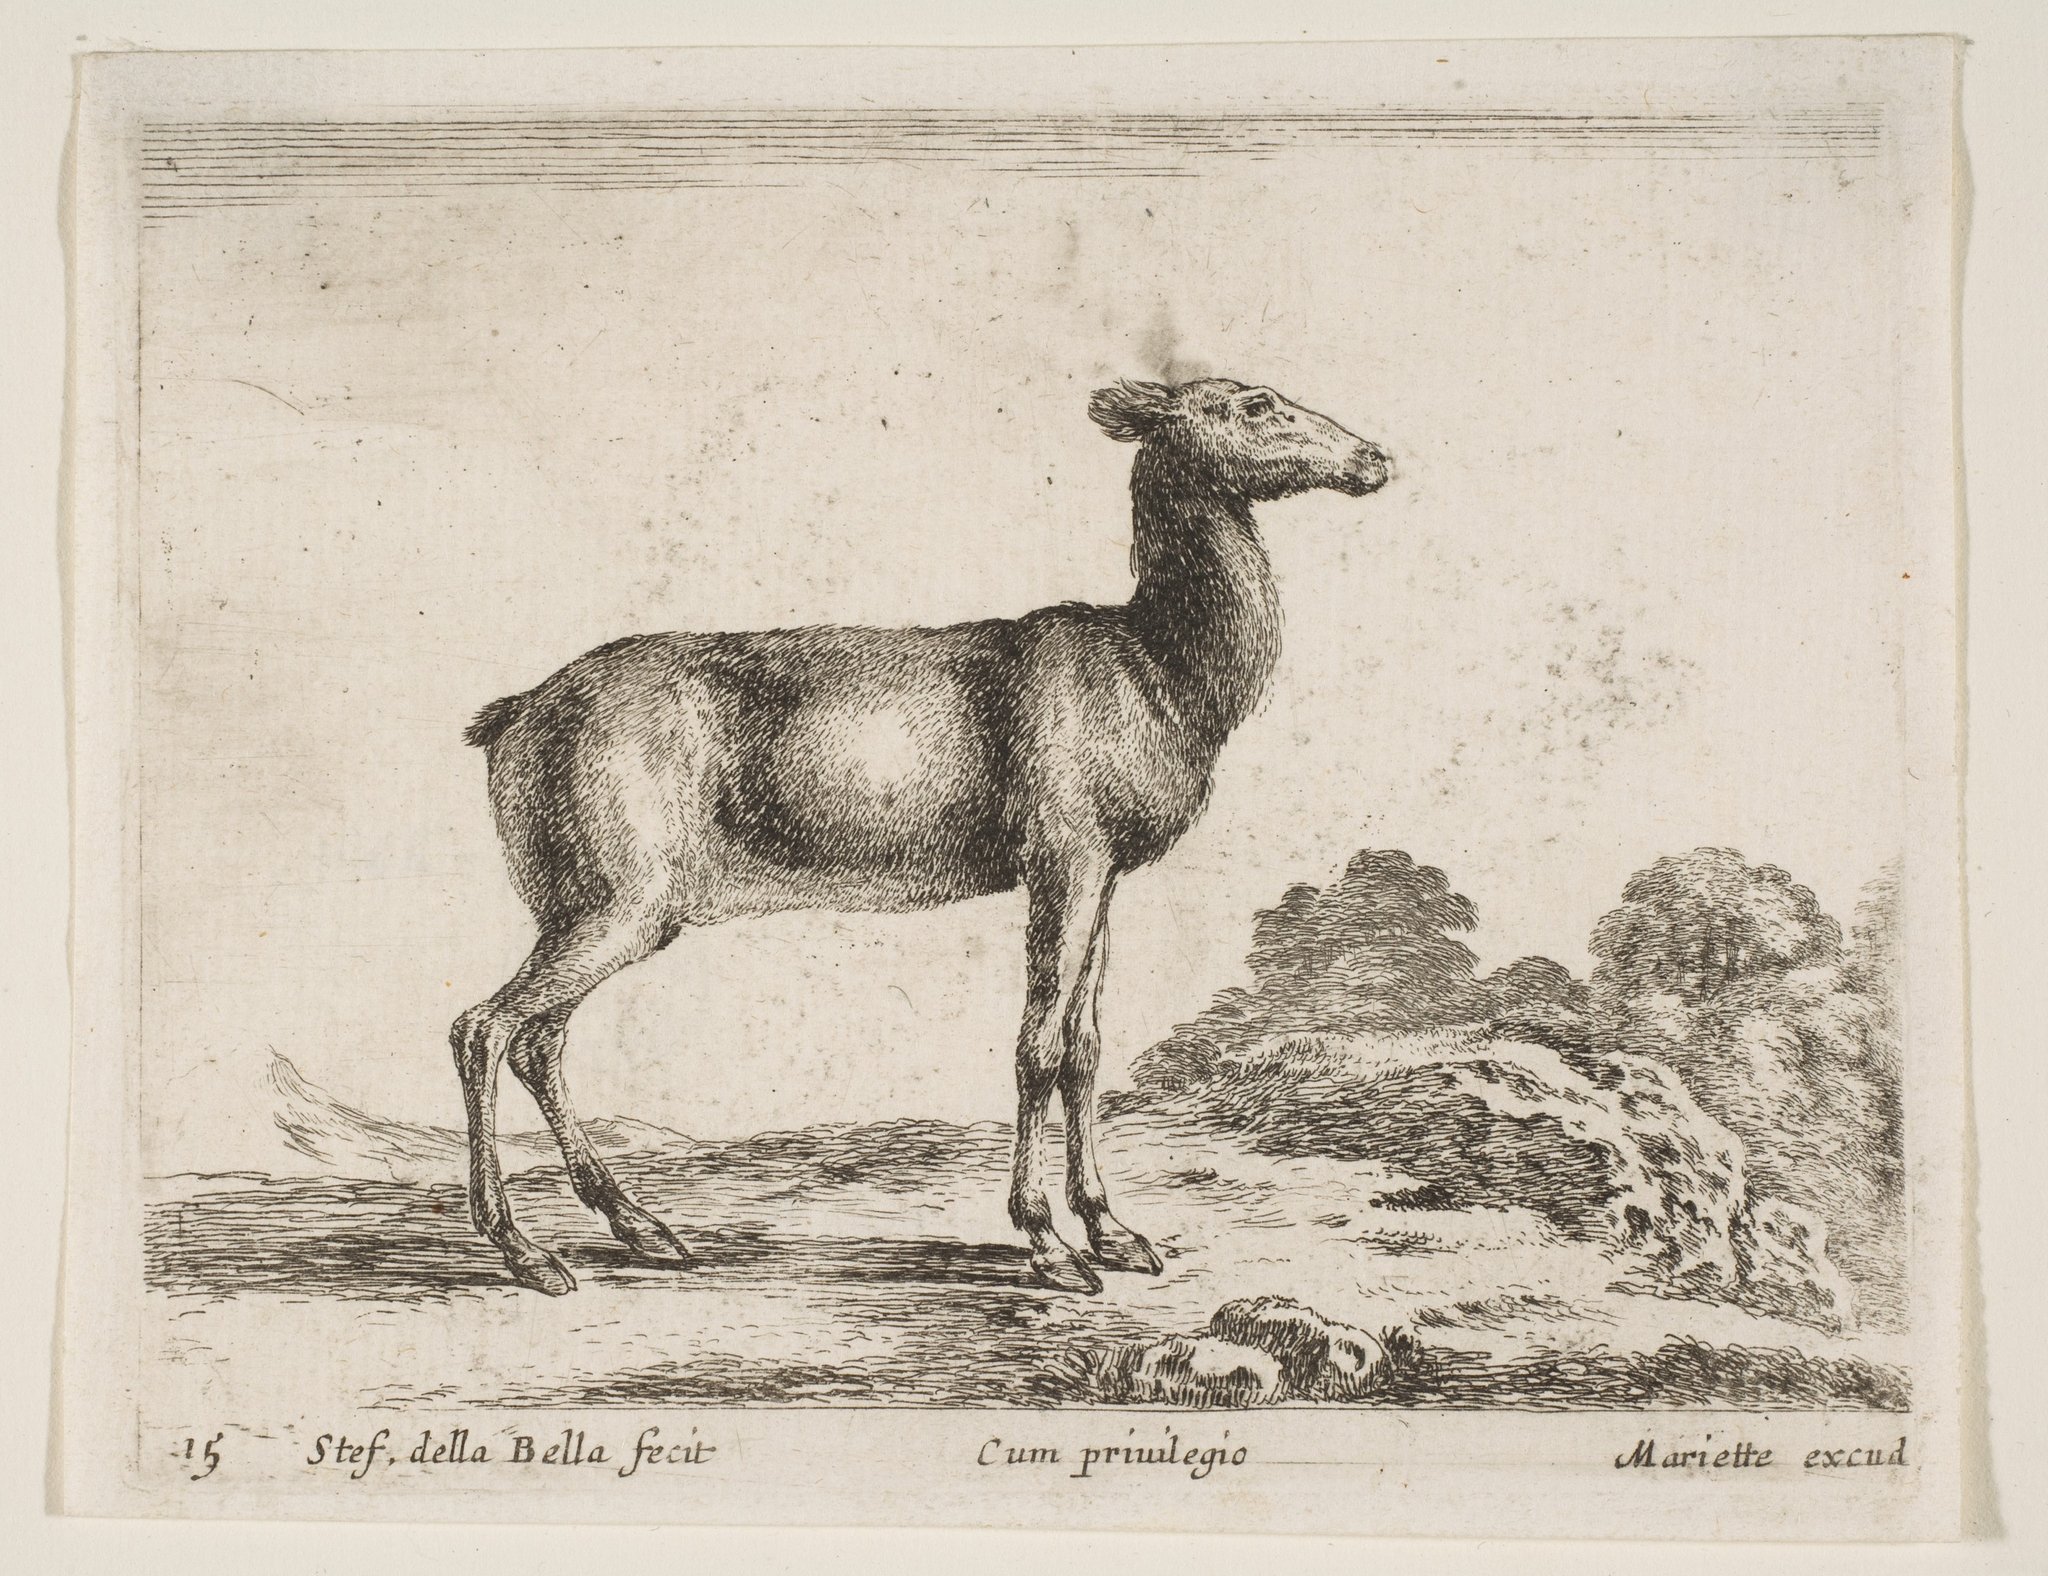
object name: print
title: Doe, plate 15 from "Various Animals" (Diversi Animali)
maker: stefano della bella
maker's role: artist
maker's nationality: italian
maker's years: 1610-1664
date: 1641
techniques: etching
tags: deer